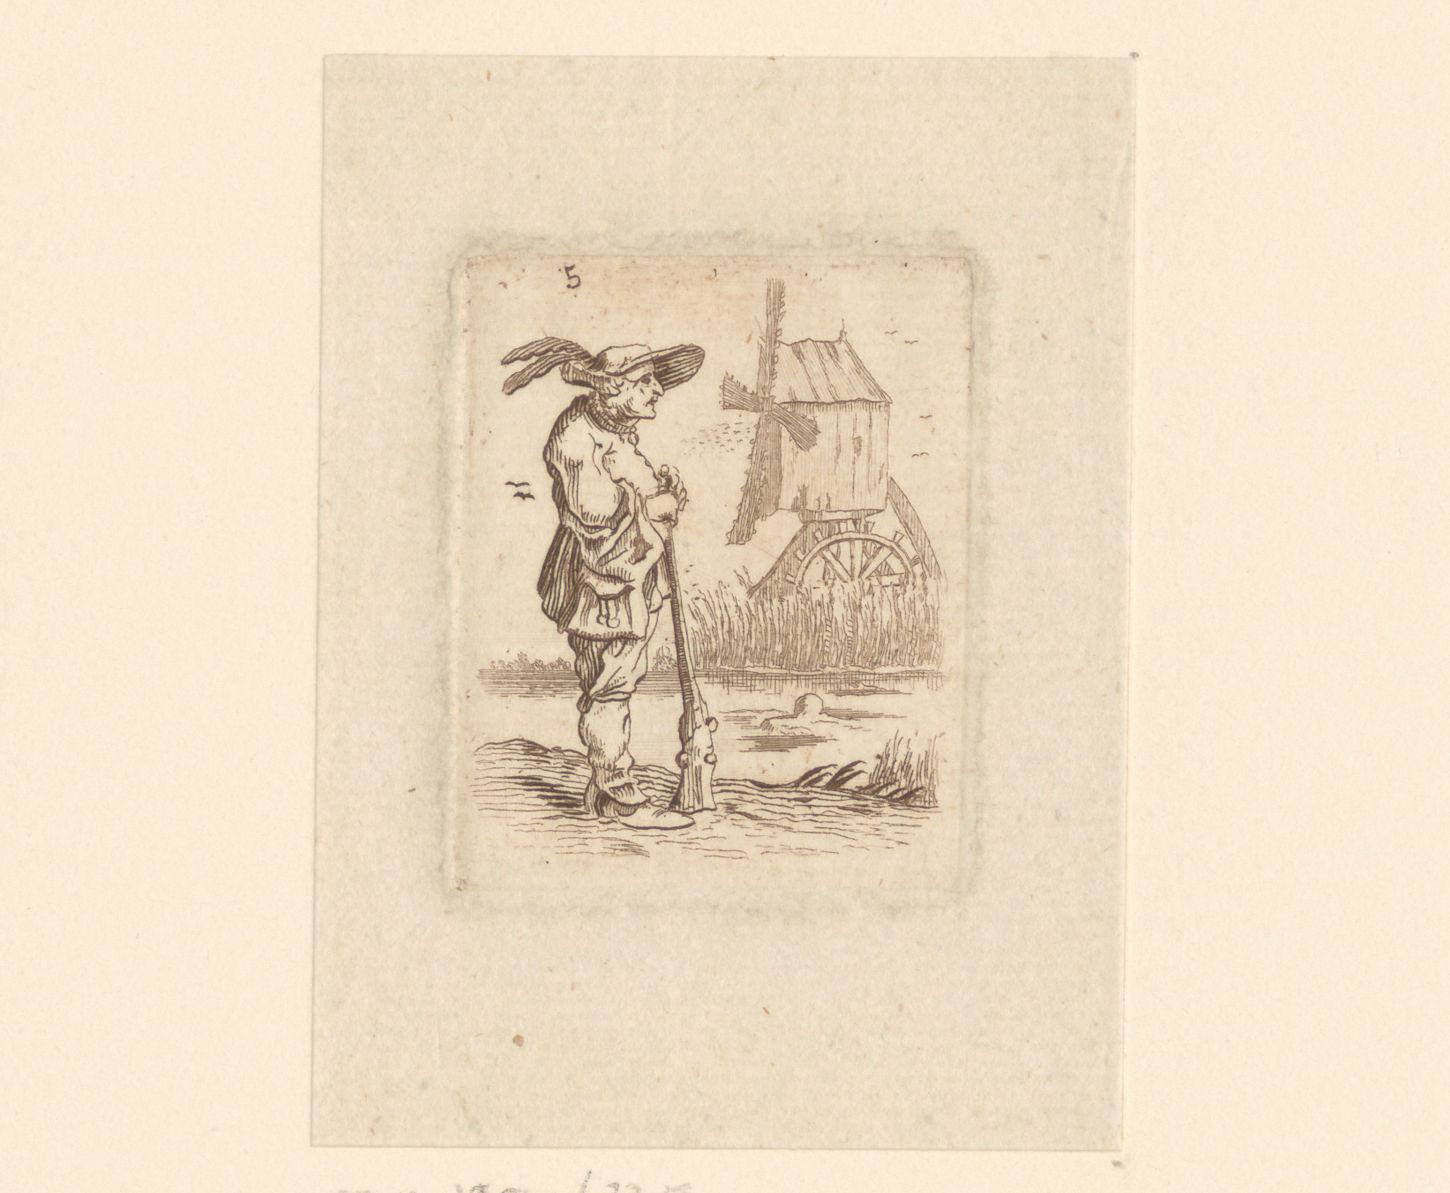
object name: print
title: Figure Subjects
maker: paul sandby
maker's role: draughtsman, print maker, publisher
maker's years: 1725-1809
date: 1735-1809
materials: paper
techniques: etching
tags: adult man, windmill in landscape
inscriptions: collector's mark: Lugt 2228